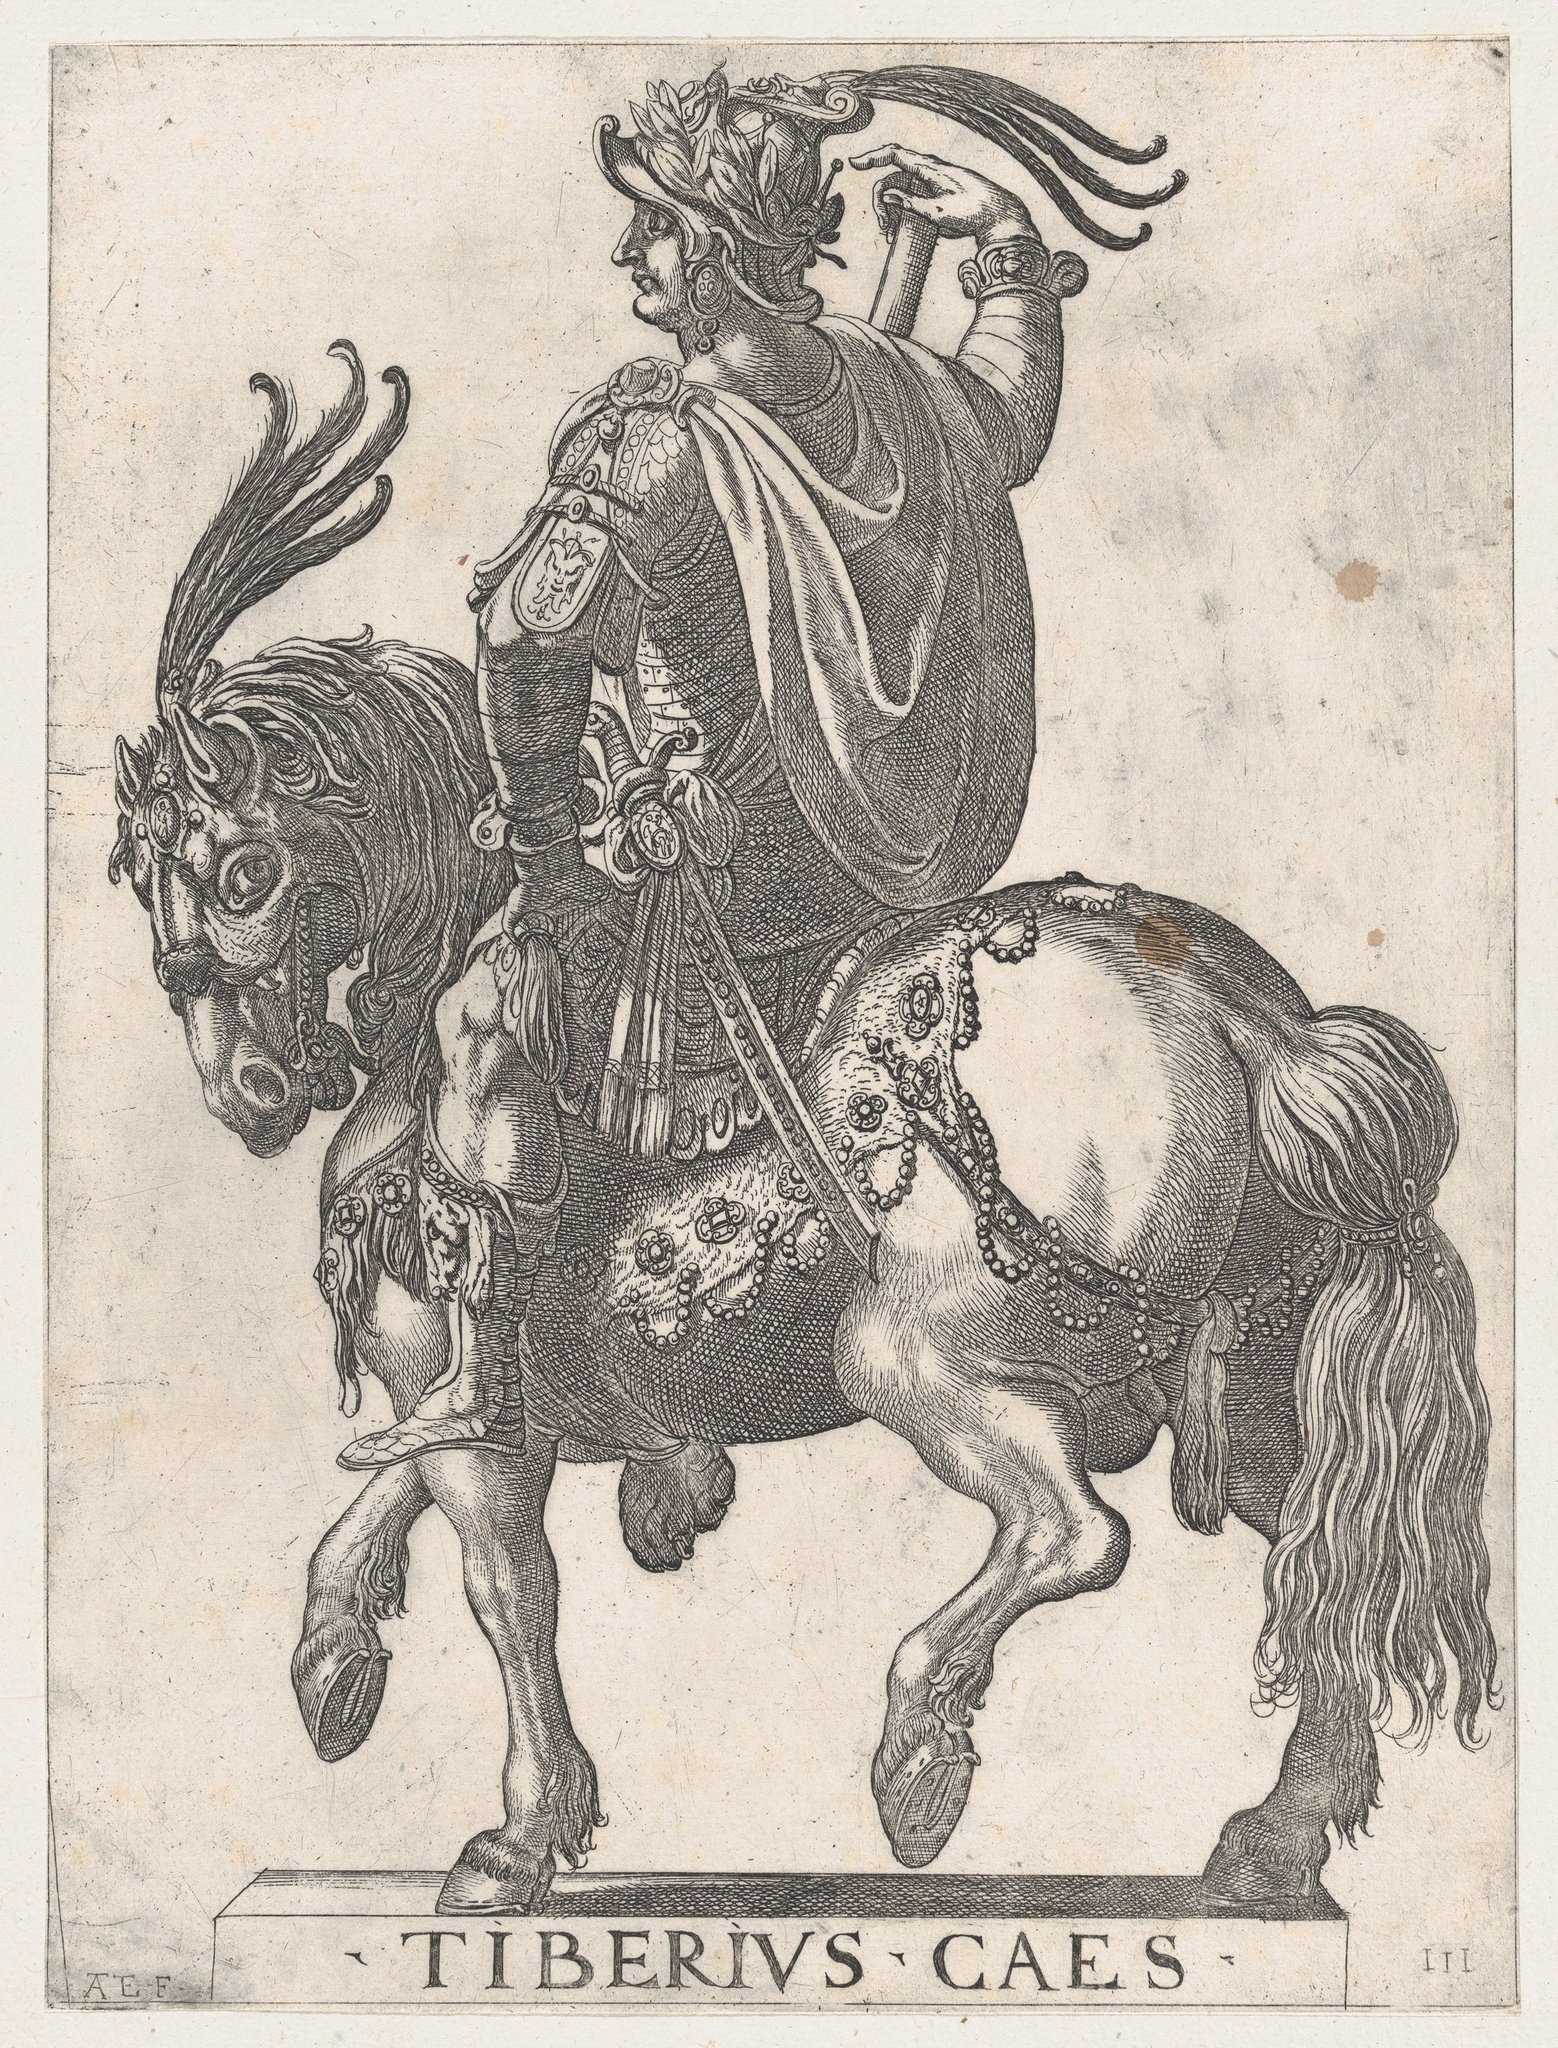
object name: print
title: Plate 3: Emperor Tiberius on Horseback, from 'The First Twelve Roman Caesars'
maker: antonio tempesta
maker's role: artist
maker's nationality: italian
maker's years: 1555-1630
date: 1596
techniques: etching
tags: swords,men,horses